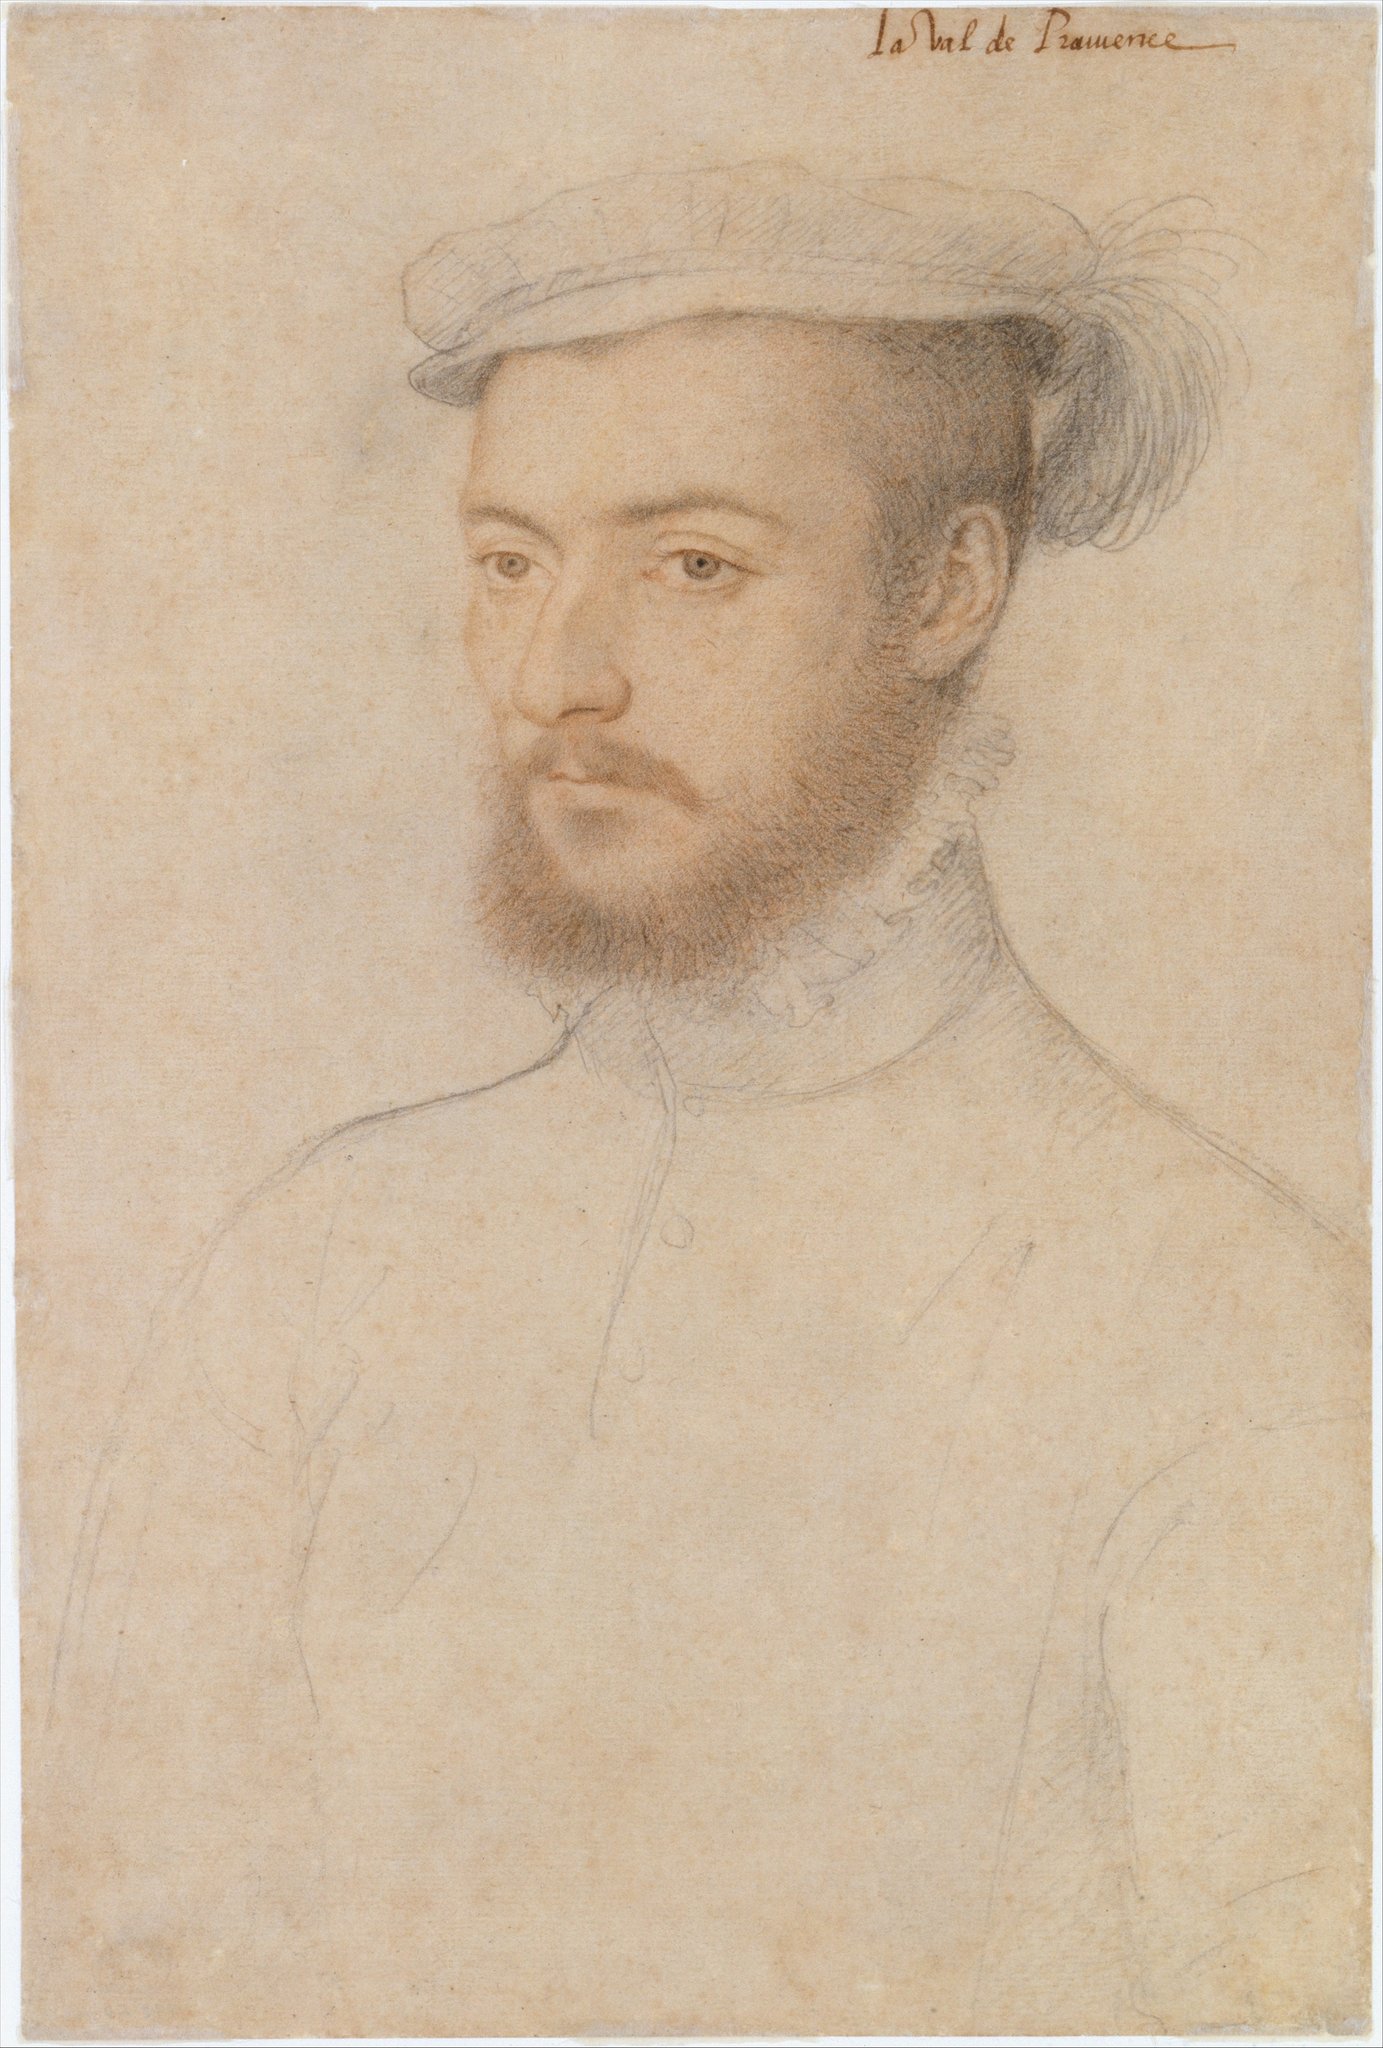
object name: drawing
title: Portrait of La Val de Pramence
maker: françois clouet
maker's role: artist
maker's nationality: french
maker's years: 1536-1572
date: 1501-1600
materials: chalk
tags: men,portraits